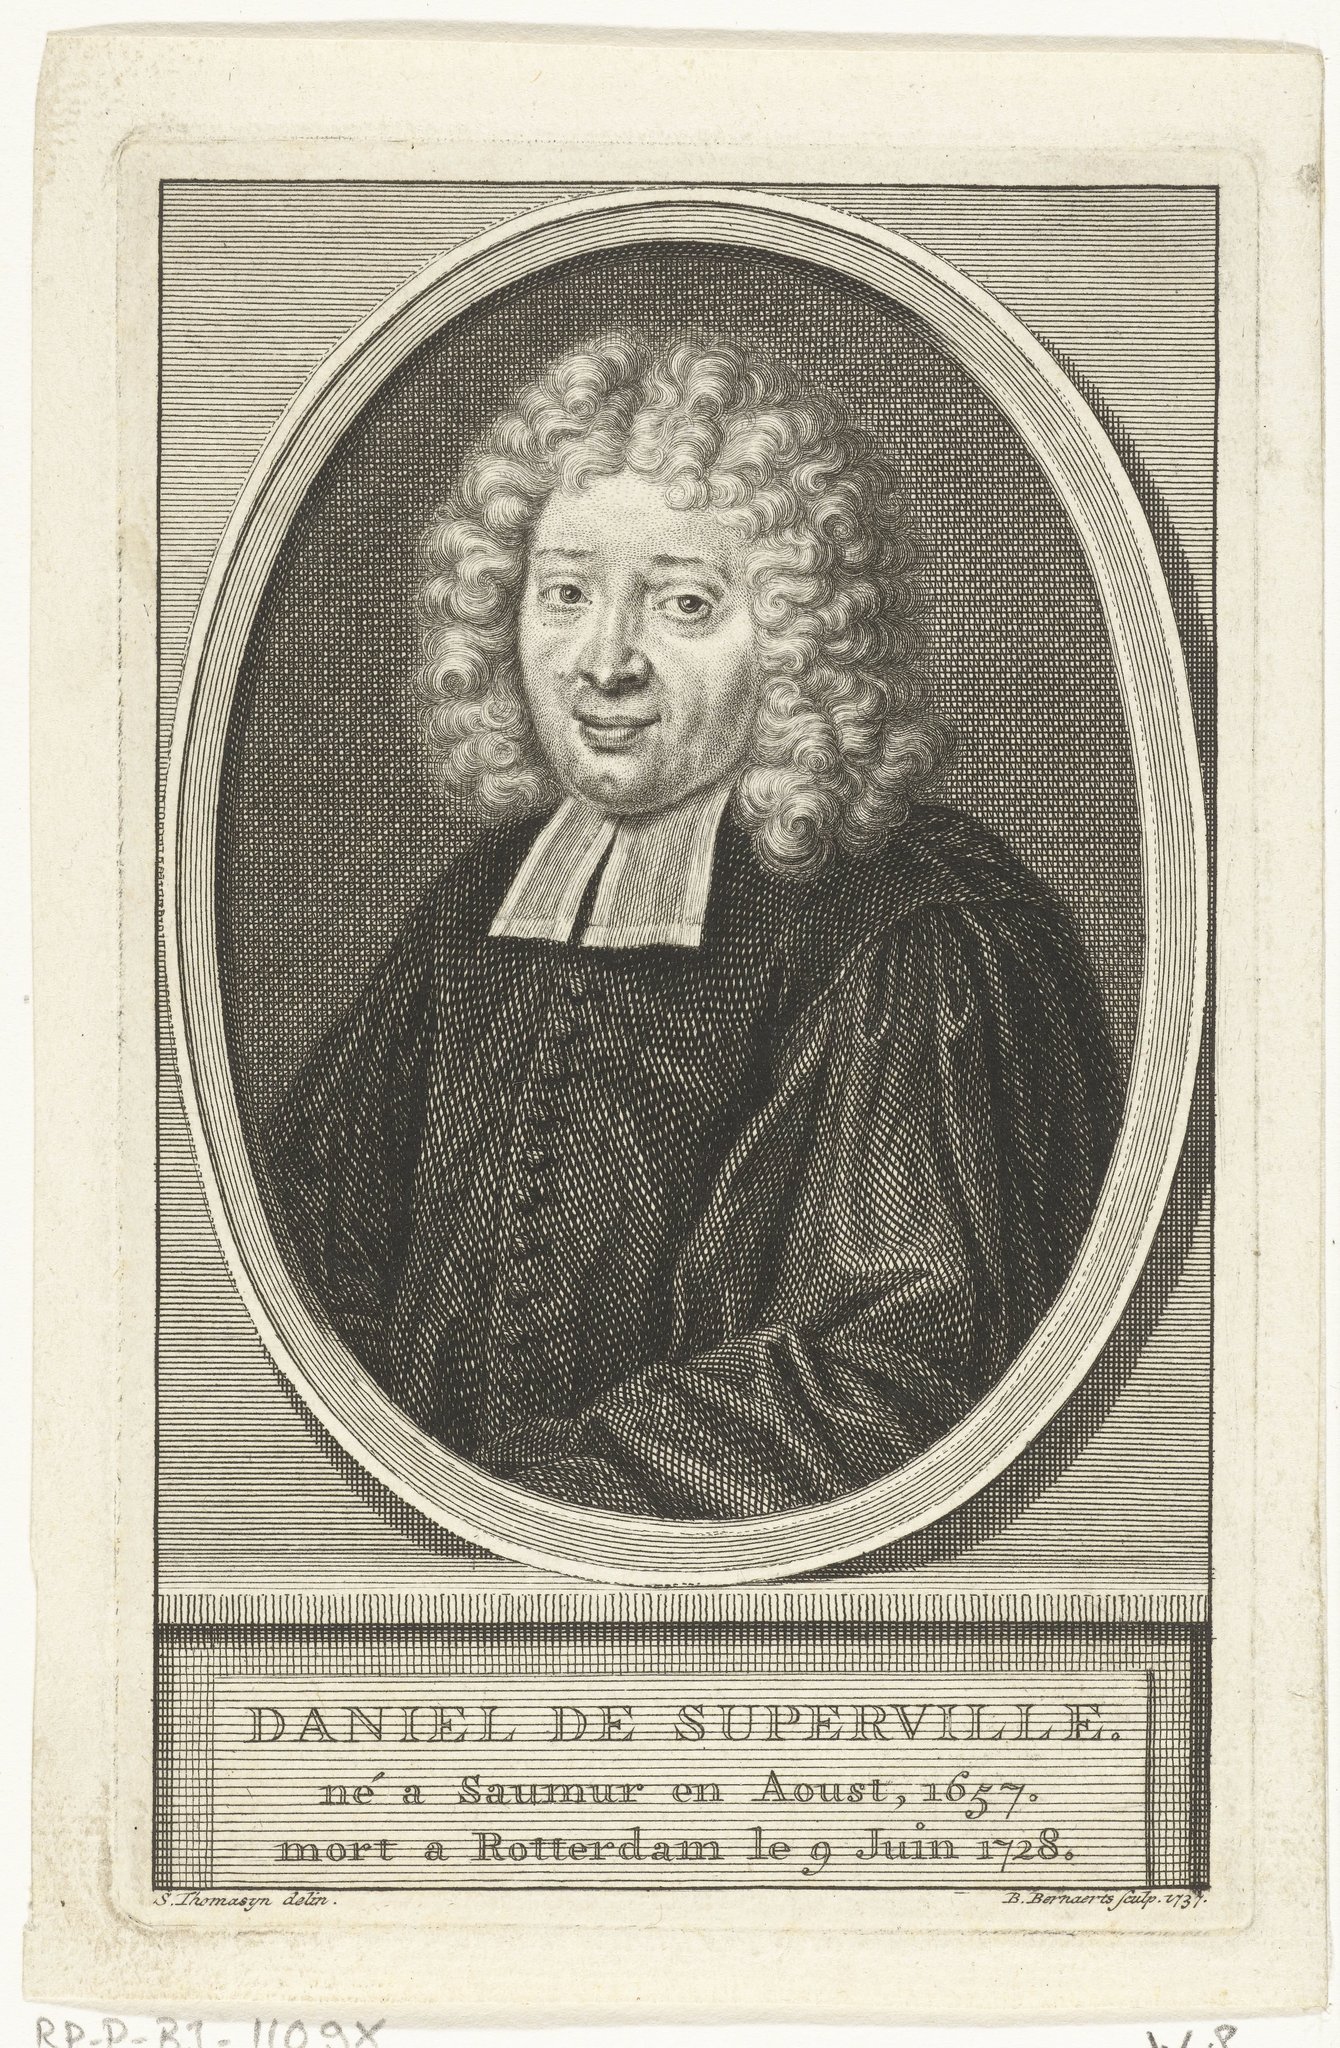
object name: print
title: Portret van Daniel de Superville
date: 1737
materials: paper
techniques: etching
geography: amsterdam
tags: rotterdam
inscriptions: collector's mark: Lugt 2228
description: Borstbeeld van de waalse predikant te Rotterdam Daniel de Superville, met toga en pruik.